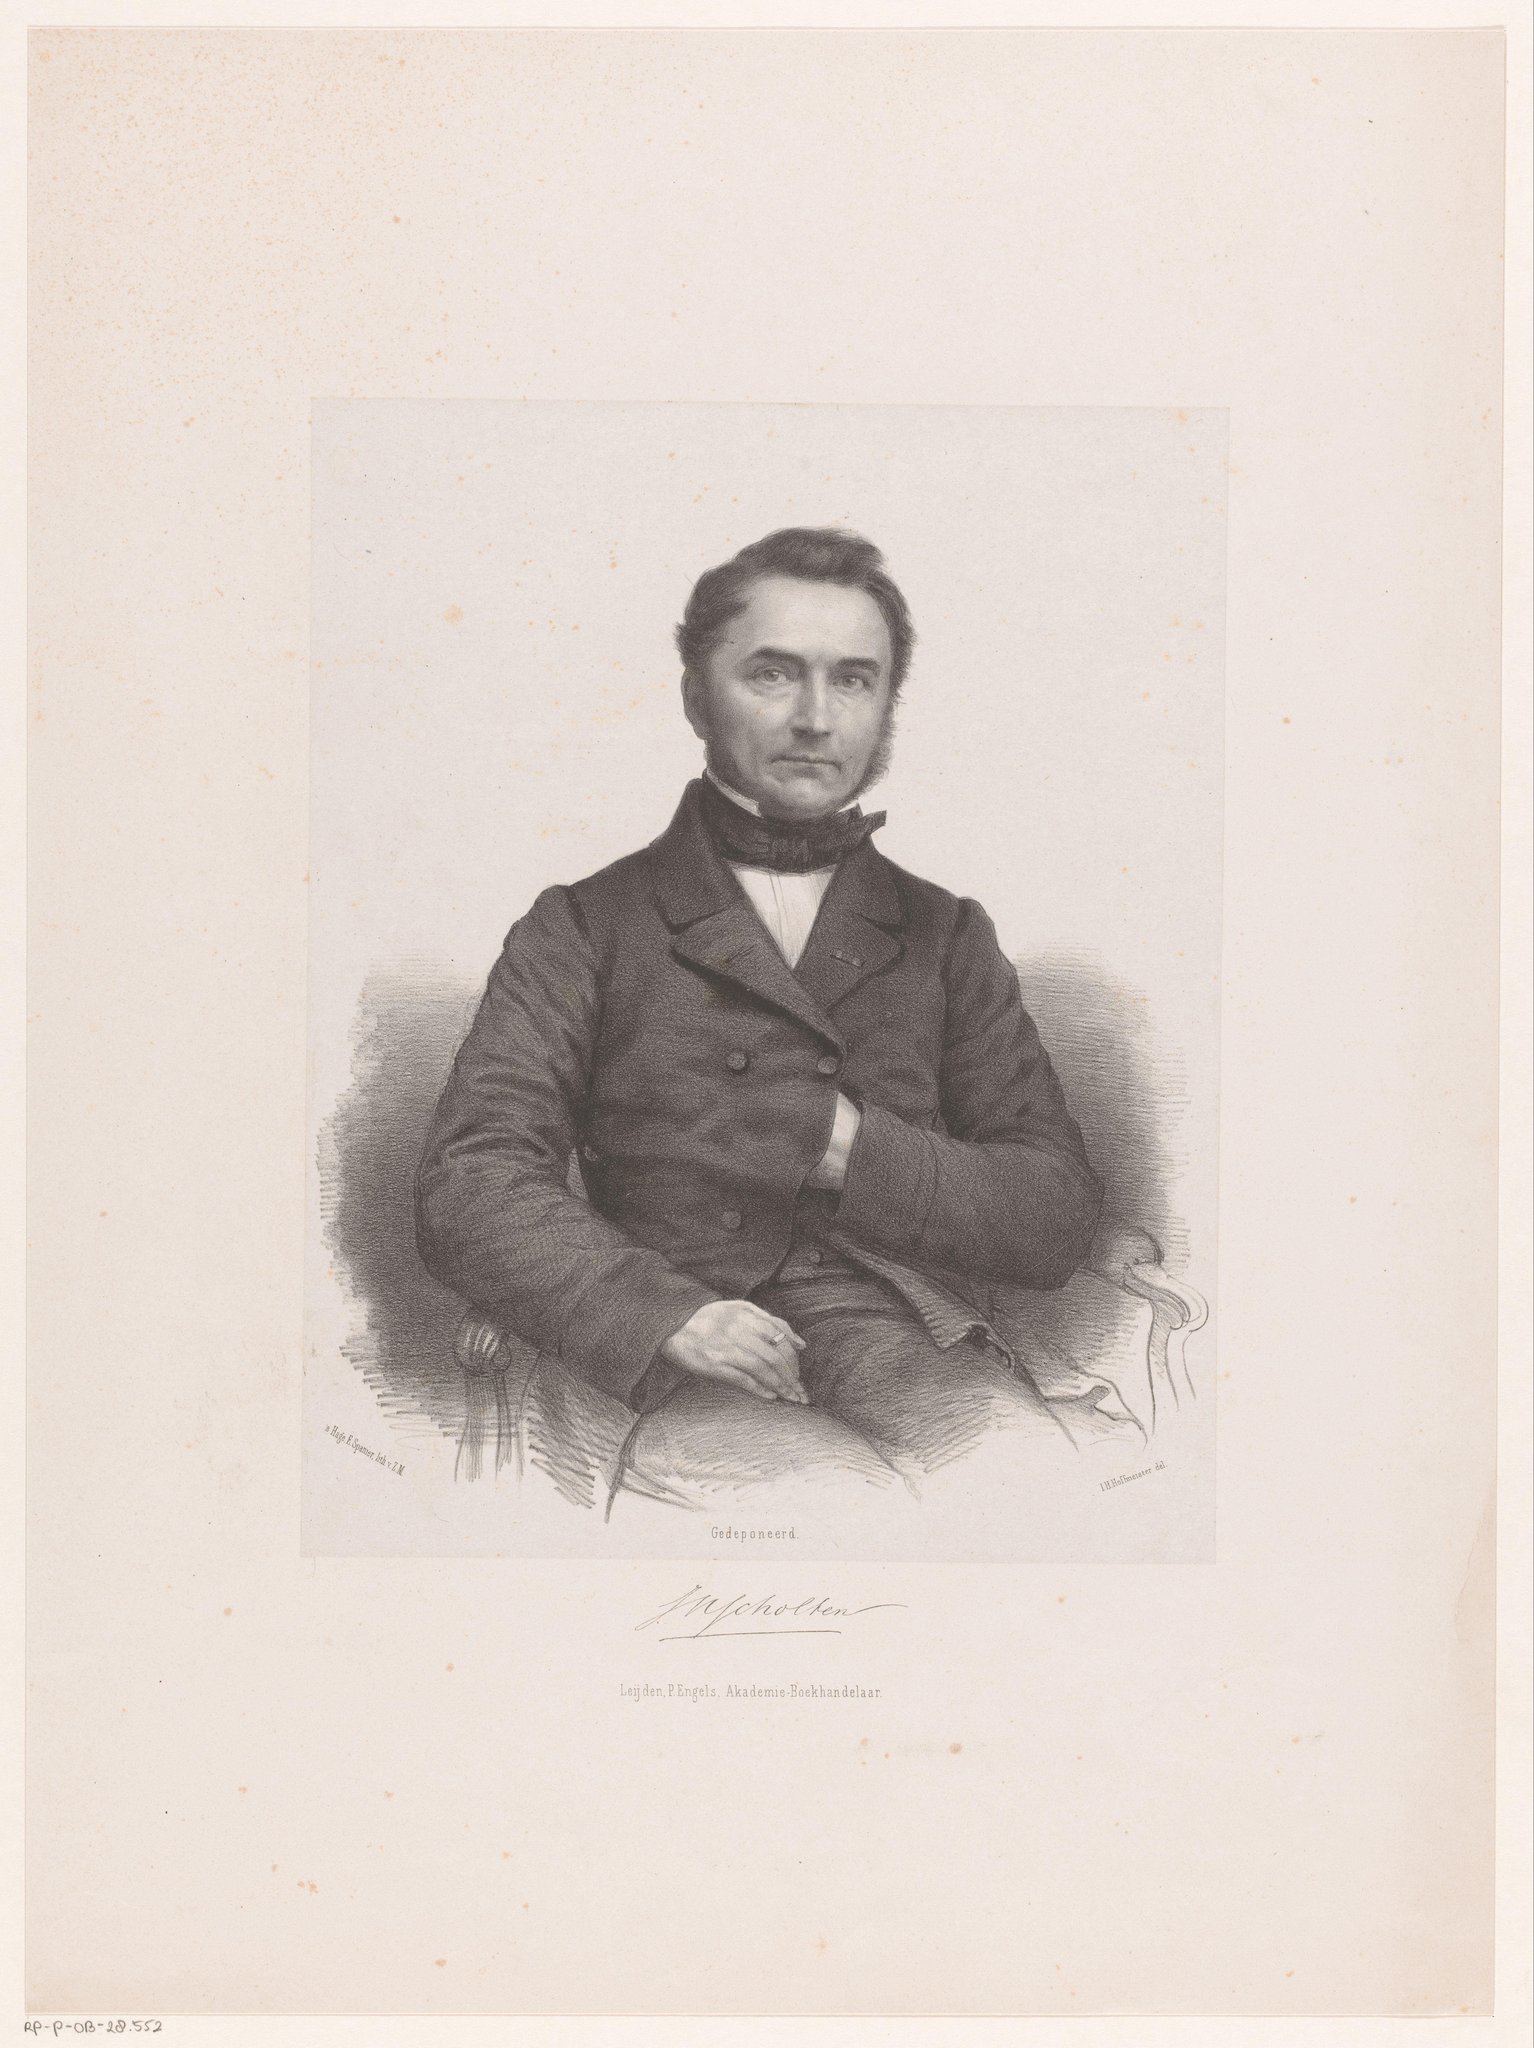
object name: print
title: Portret van Johannes Henricus Scholten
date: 1851-1883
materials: paper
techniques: lithograph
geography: netherlands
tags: historical persons (+ (full) bust portrait)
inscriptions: collector's mark: Lugt 2228, : ‘Gedeponeerd.’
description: Onder het portret de signatuur van de geportretteerde.